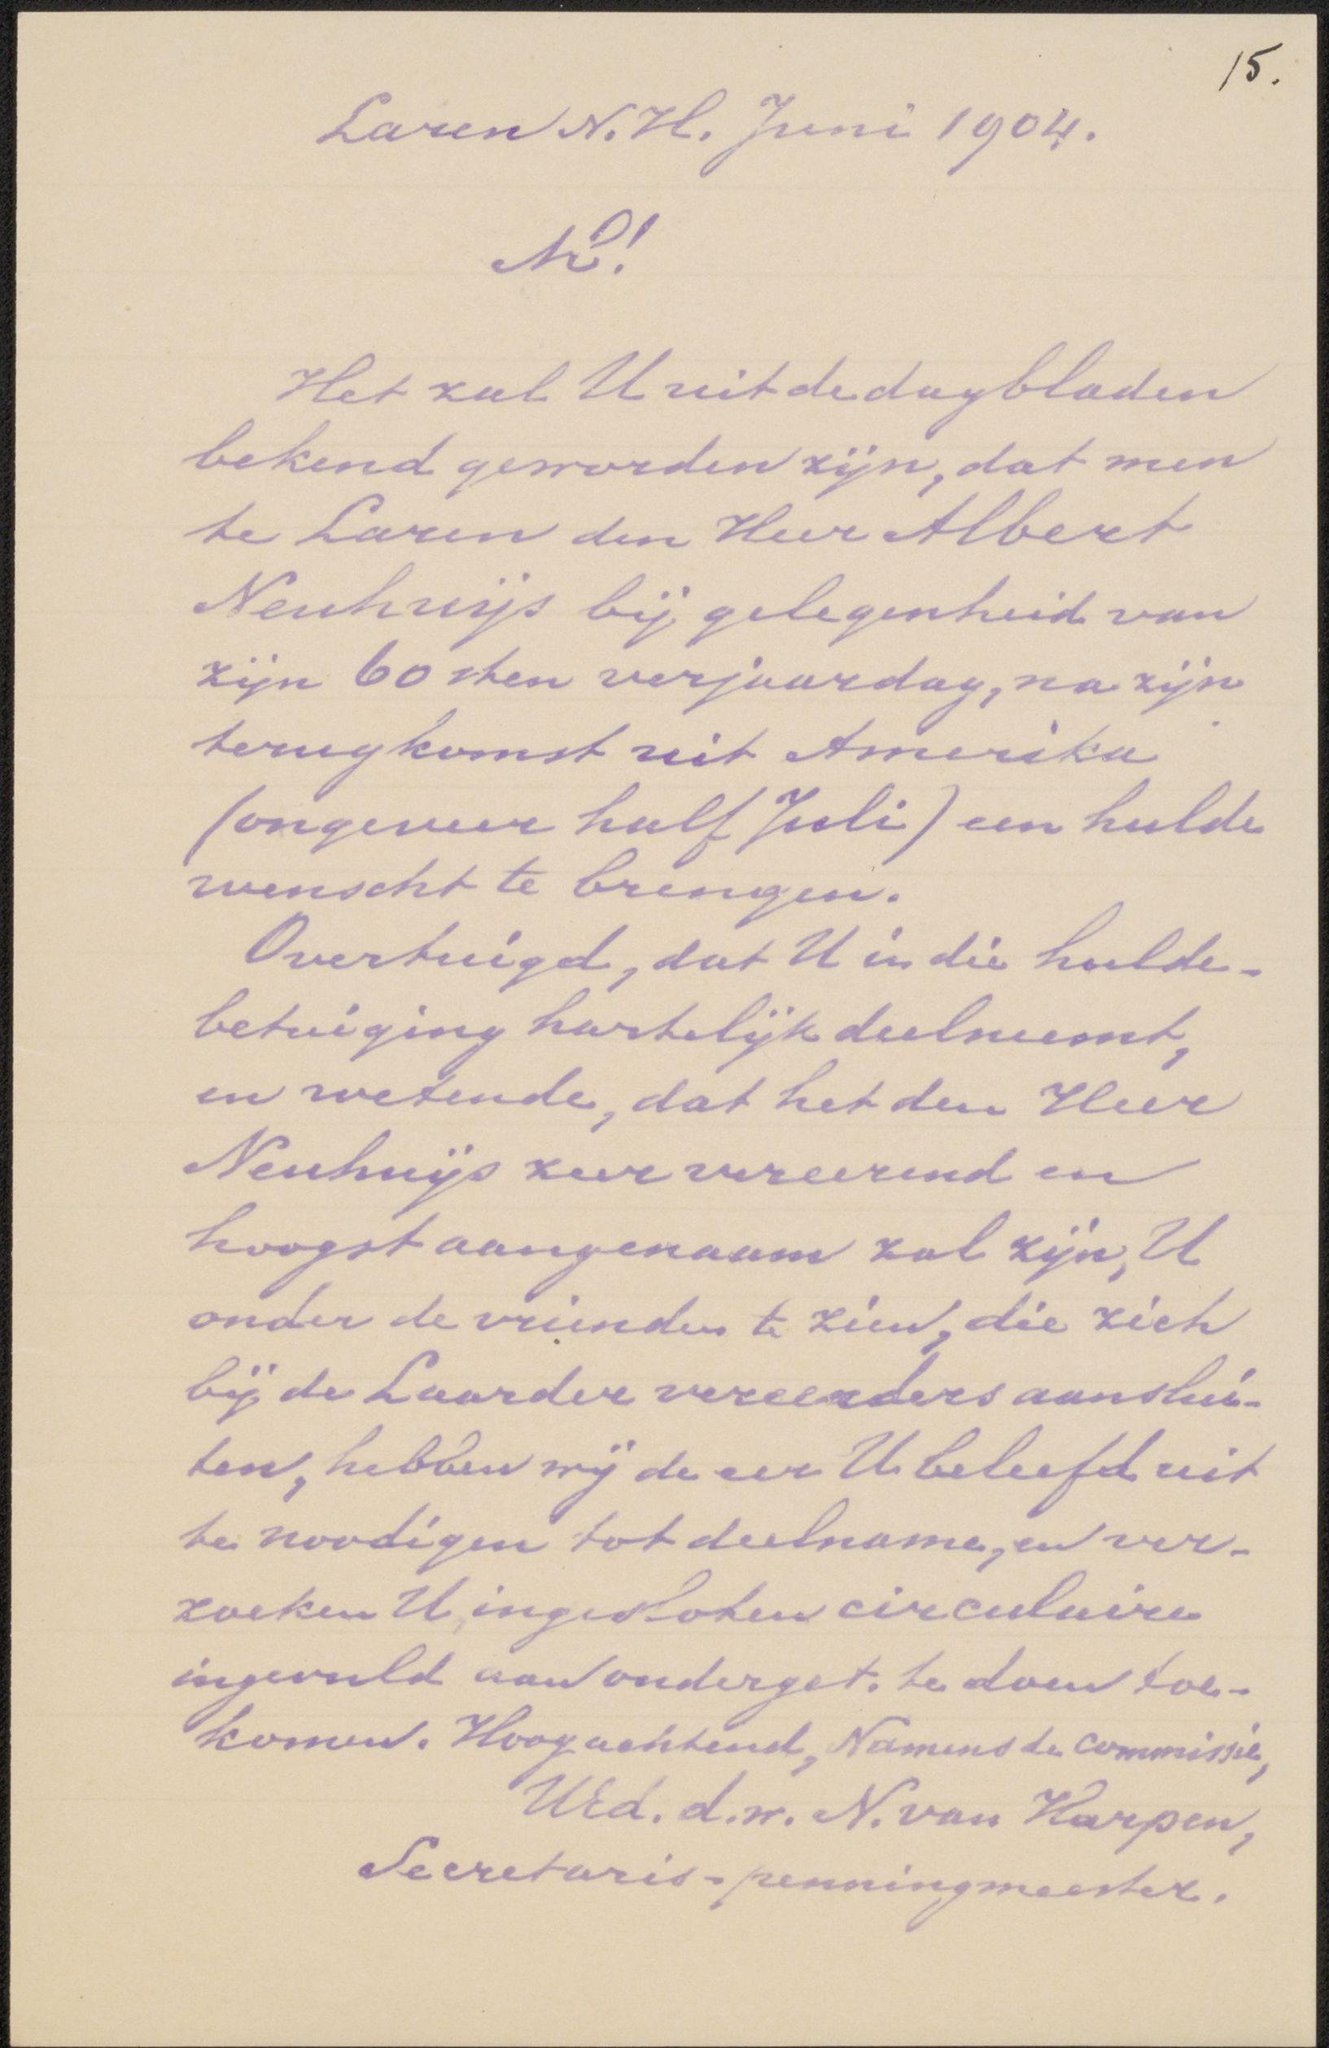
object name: letter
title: Brief aan anoniem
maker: nico van harpen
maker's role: kunsthandelaar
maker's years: 1858-1931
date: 1904-1906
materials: ink, paper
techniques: pen, writing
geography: laren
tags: utrecht, painter, print maker, draughtsman, albert neuhuys (1844-1914)